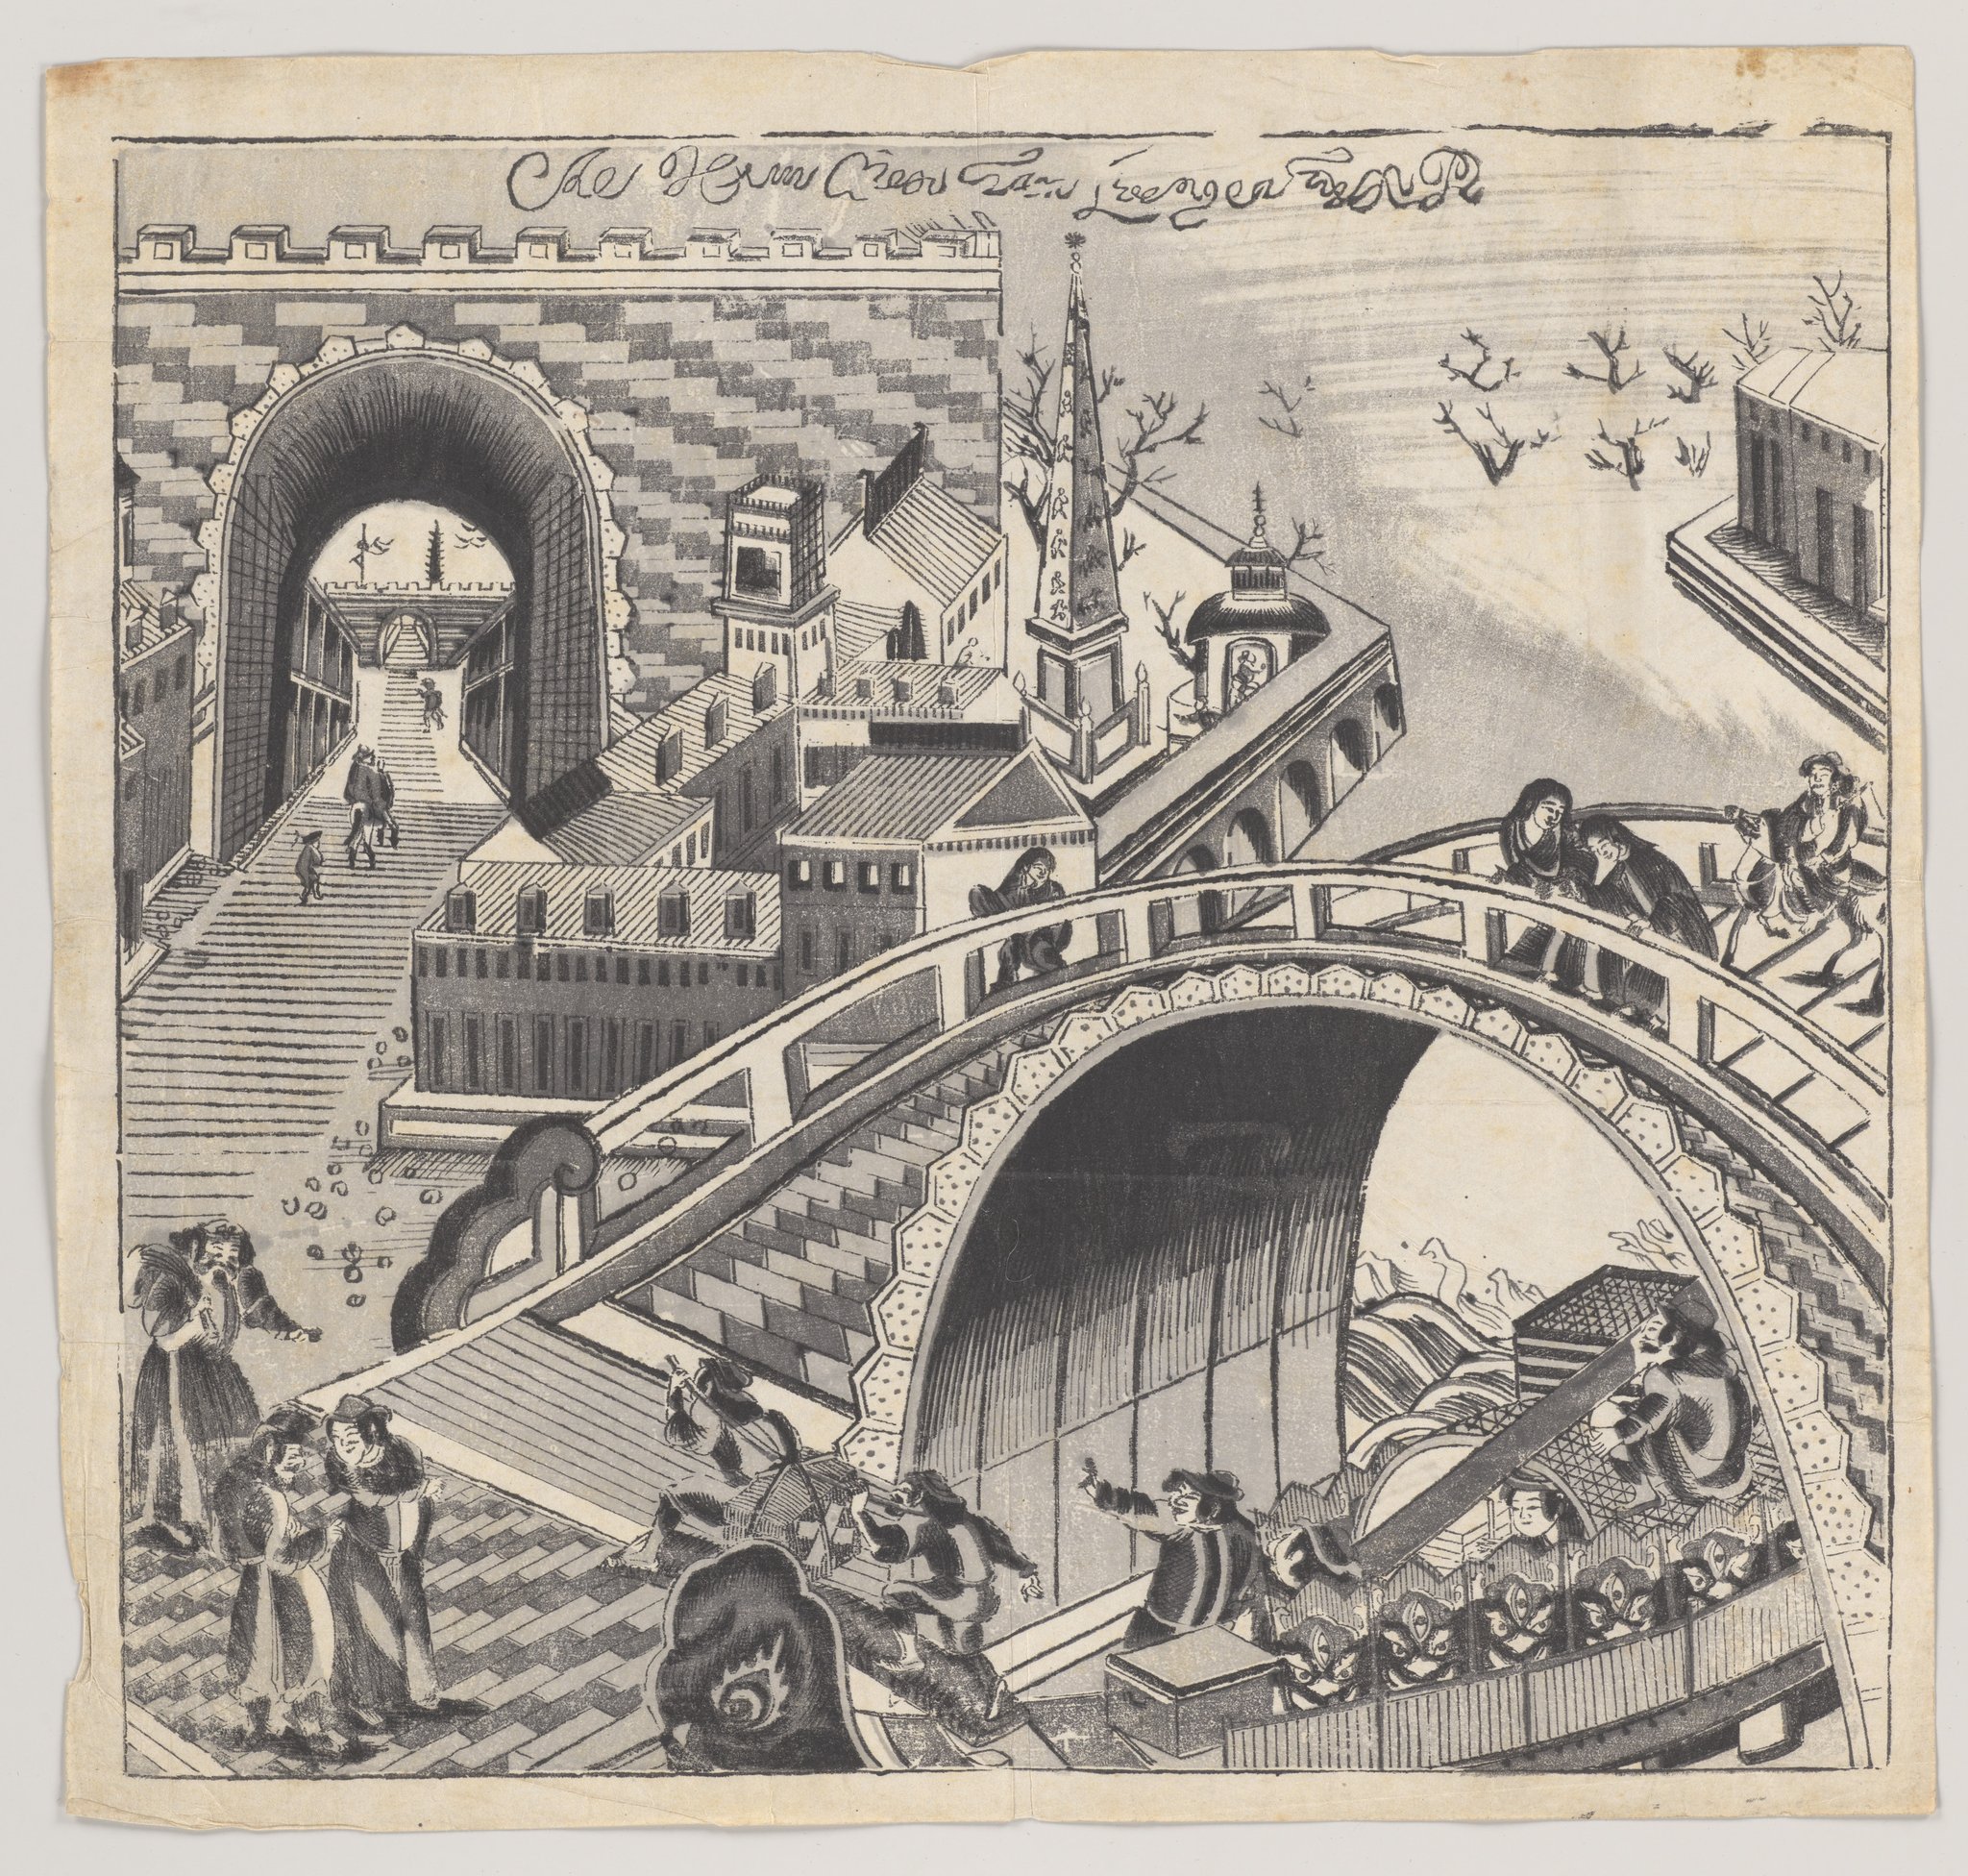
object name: print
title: Print in Western Style with Western Text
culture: chinese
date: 1662-1735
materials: ink, paper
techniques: woodblock print